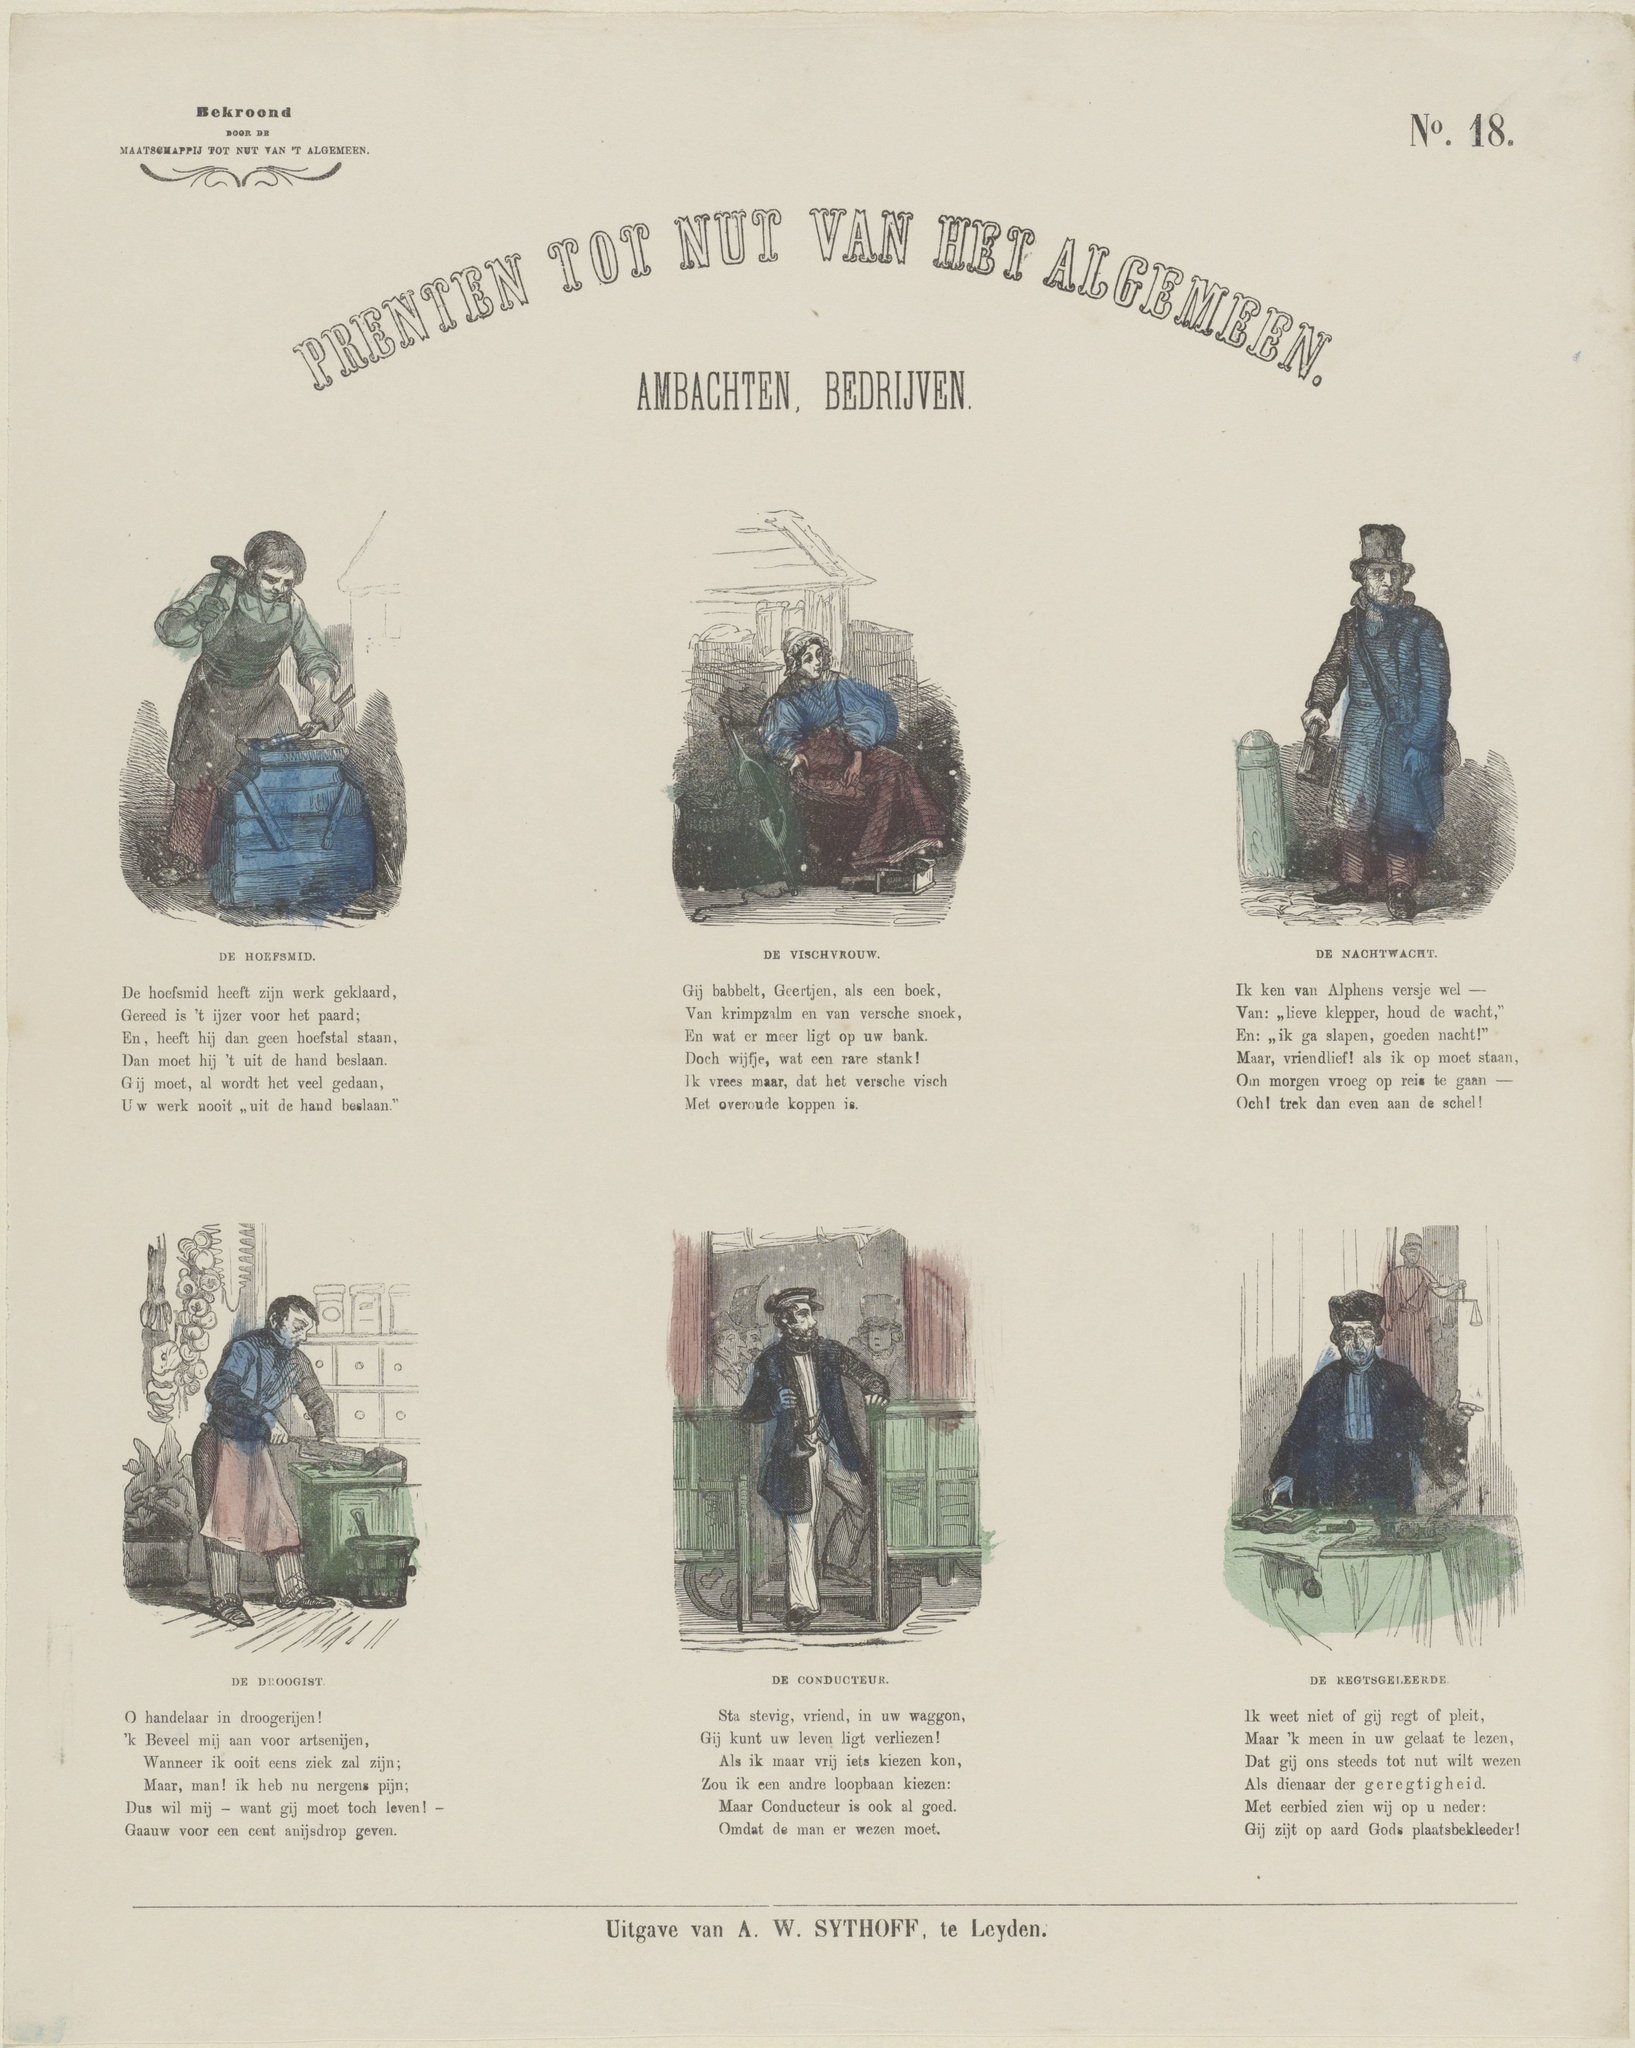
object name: popular print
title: Prenten tot nut van het algemeen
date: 1861-1929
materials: paper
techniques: colour, letterpress printing, engraving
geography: europe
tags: craft-production, skilled handiwork, pharmacist, druggist, apothecary; pharmacy, drugstore, dispensing chemist, smith, blacksmith, crafts and industries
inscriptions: collector's mark: Lugt 2760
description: Blad met 6 voorstellingen van ambachtslieden en beroepen, zoals een hoefsmid, een visvrouw en een drogist. Onder elke afbeelding een titel en een vers. Genummerd rechtsboven: No. 18. Linksboven: Bekroond door de Maatschappij tot Nut van 't Algemeen.